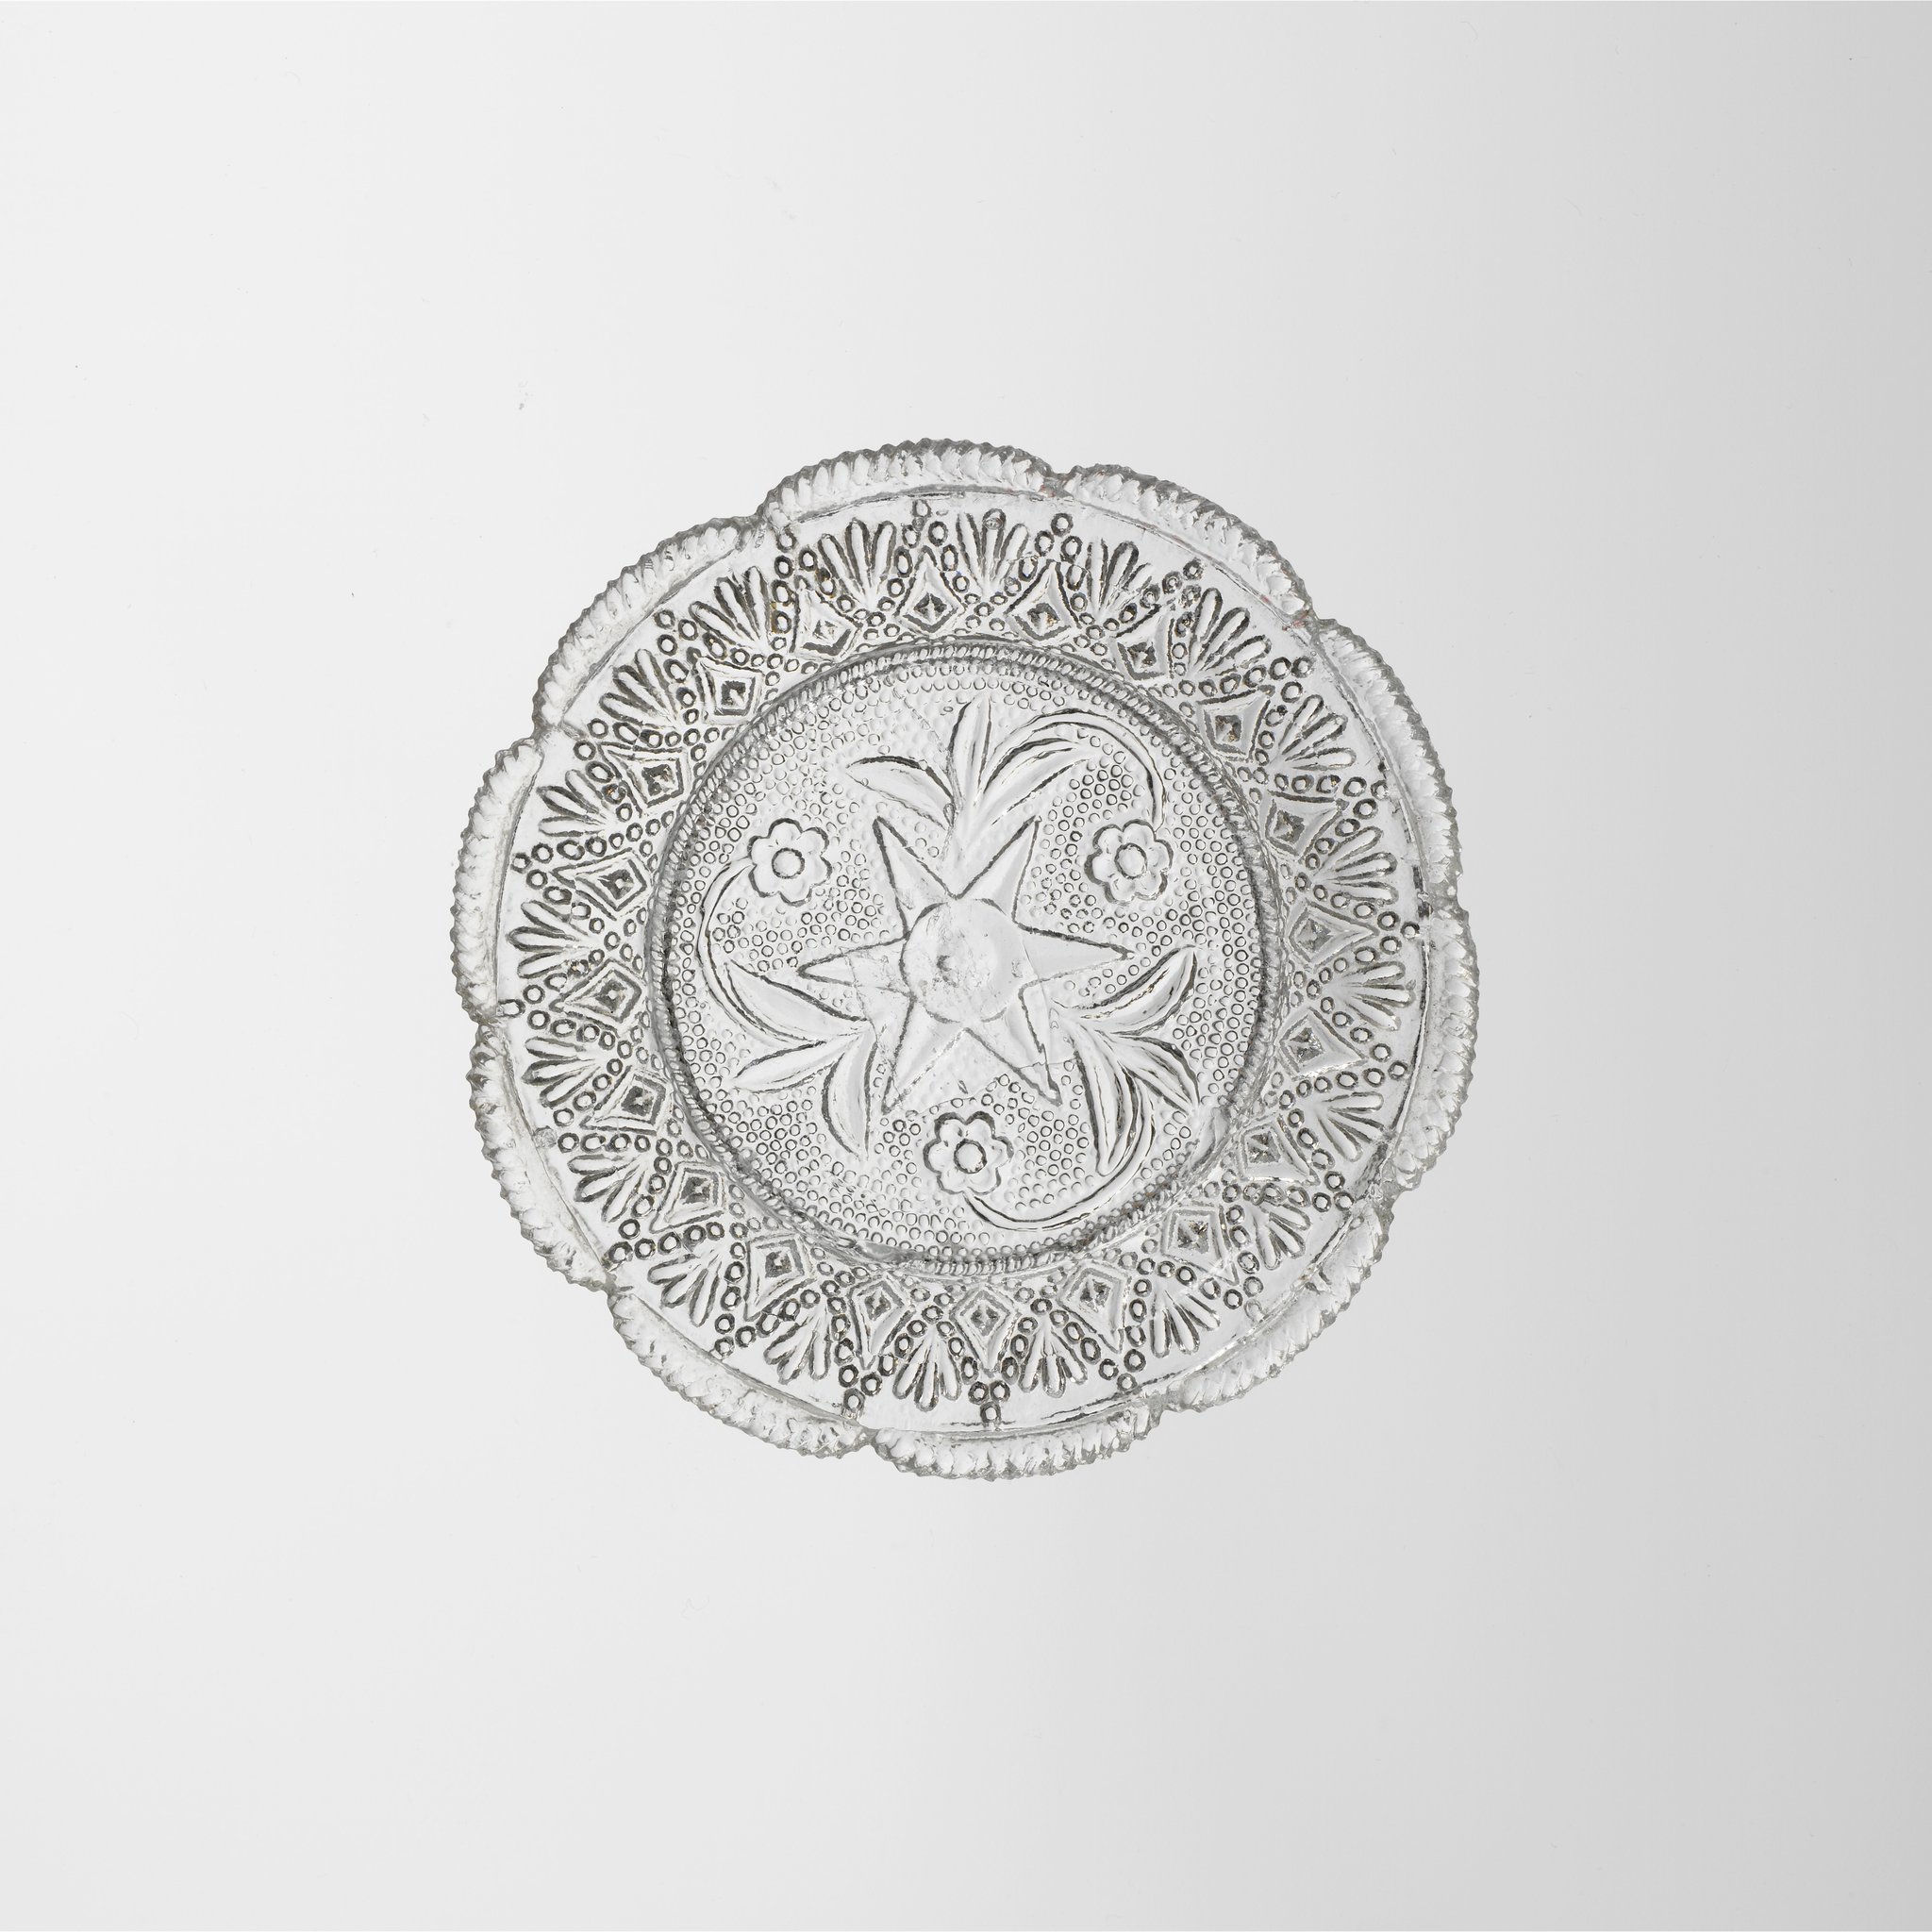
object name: cup plate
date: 1825-1860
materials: glass